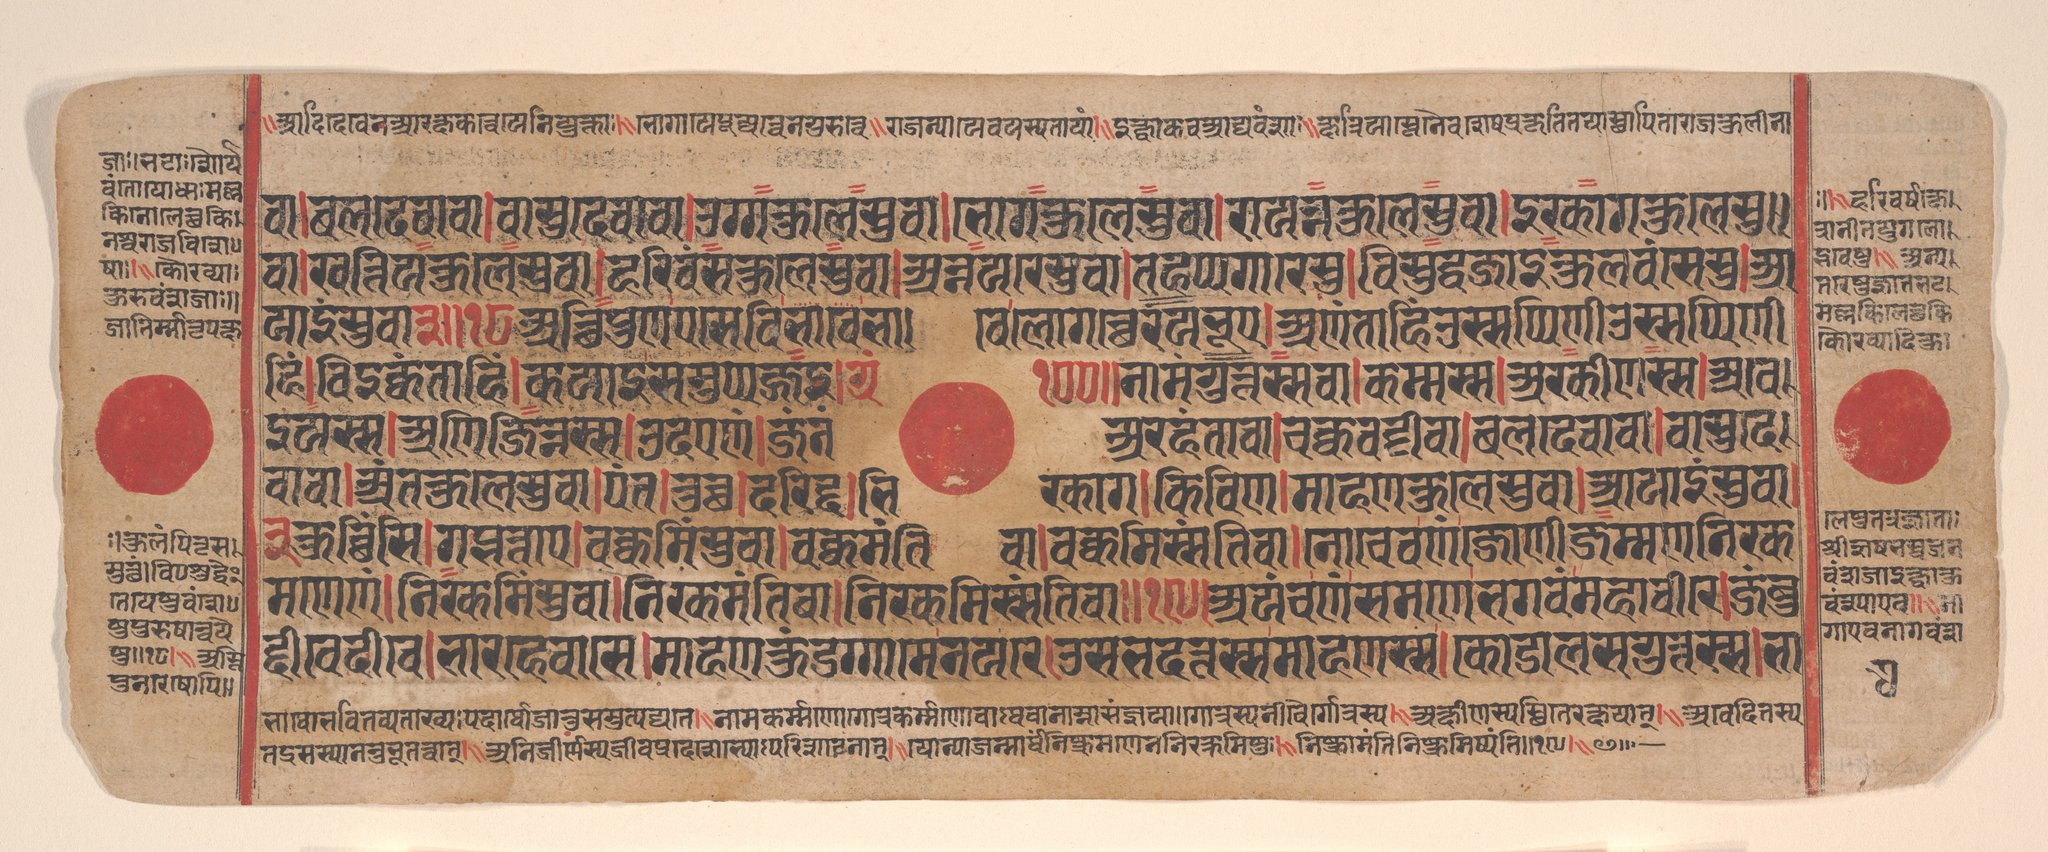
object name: folio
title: Leaf from a Kalpa Sutra (Jain Book of Rituals)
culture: indian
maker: bhadrabahu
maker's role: artist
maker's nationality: indian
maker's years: 356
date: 1401-1500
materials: gold, ink, paper, watercolor